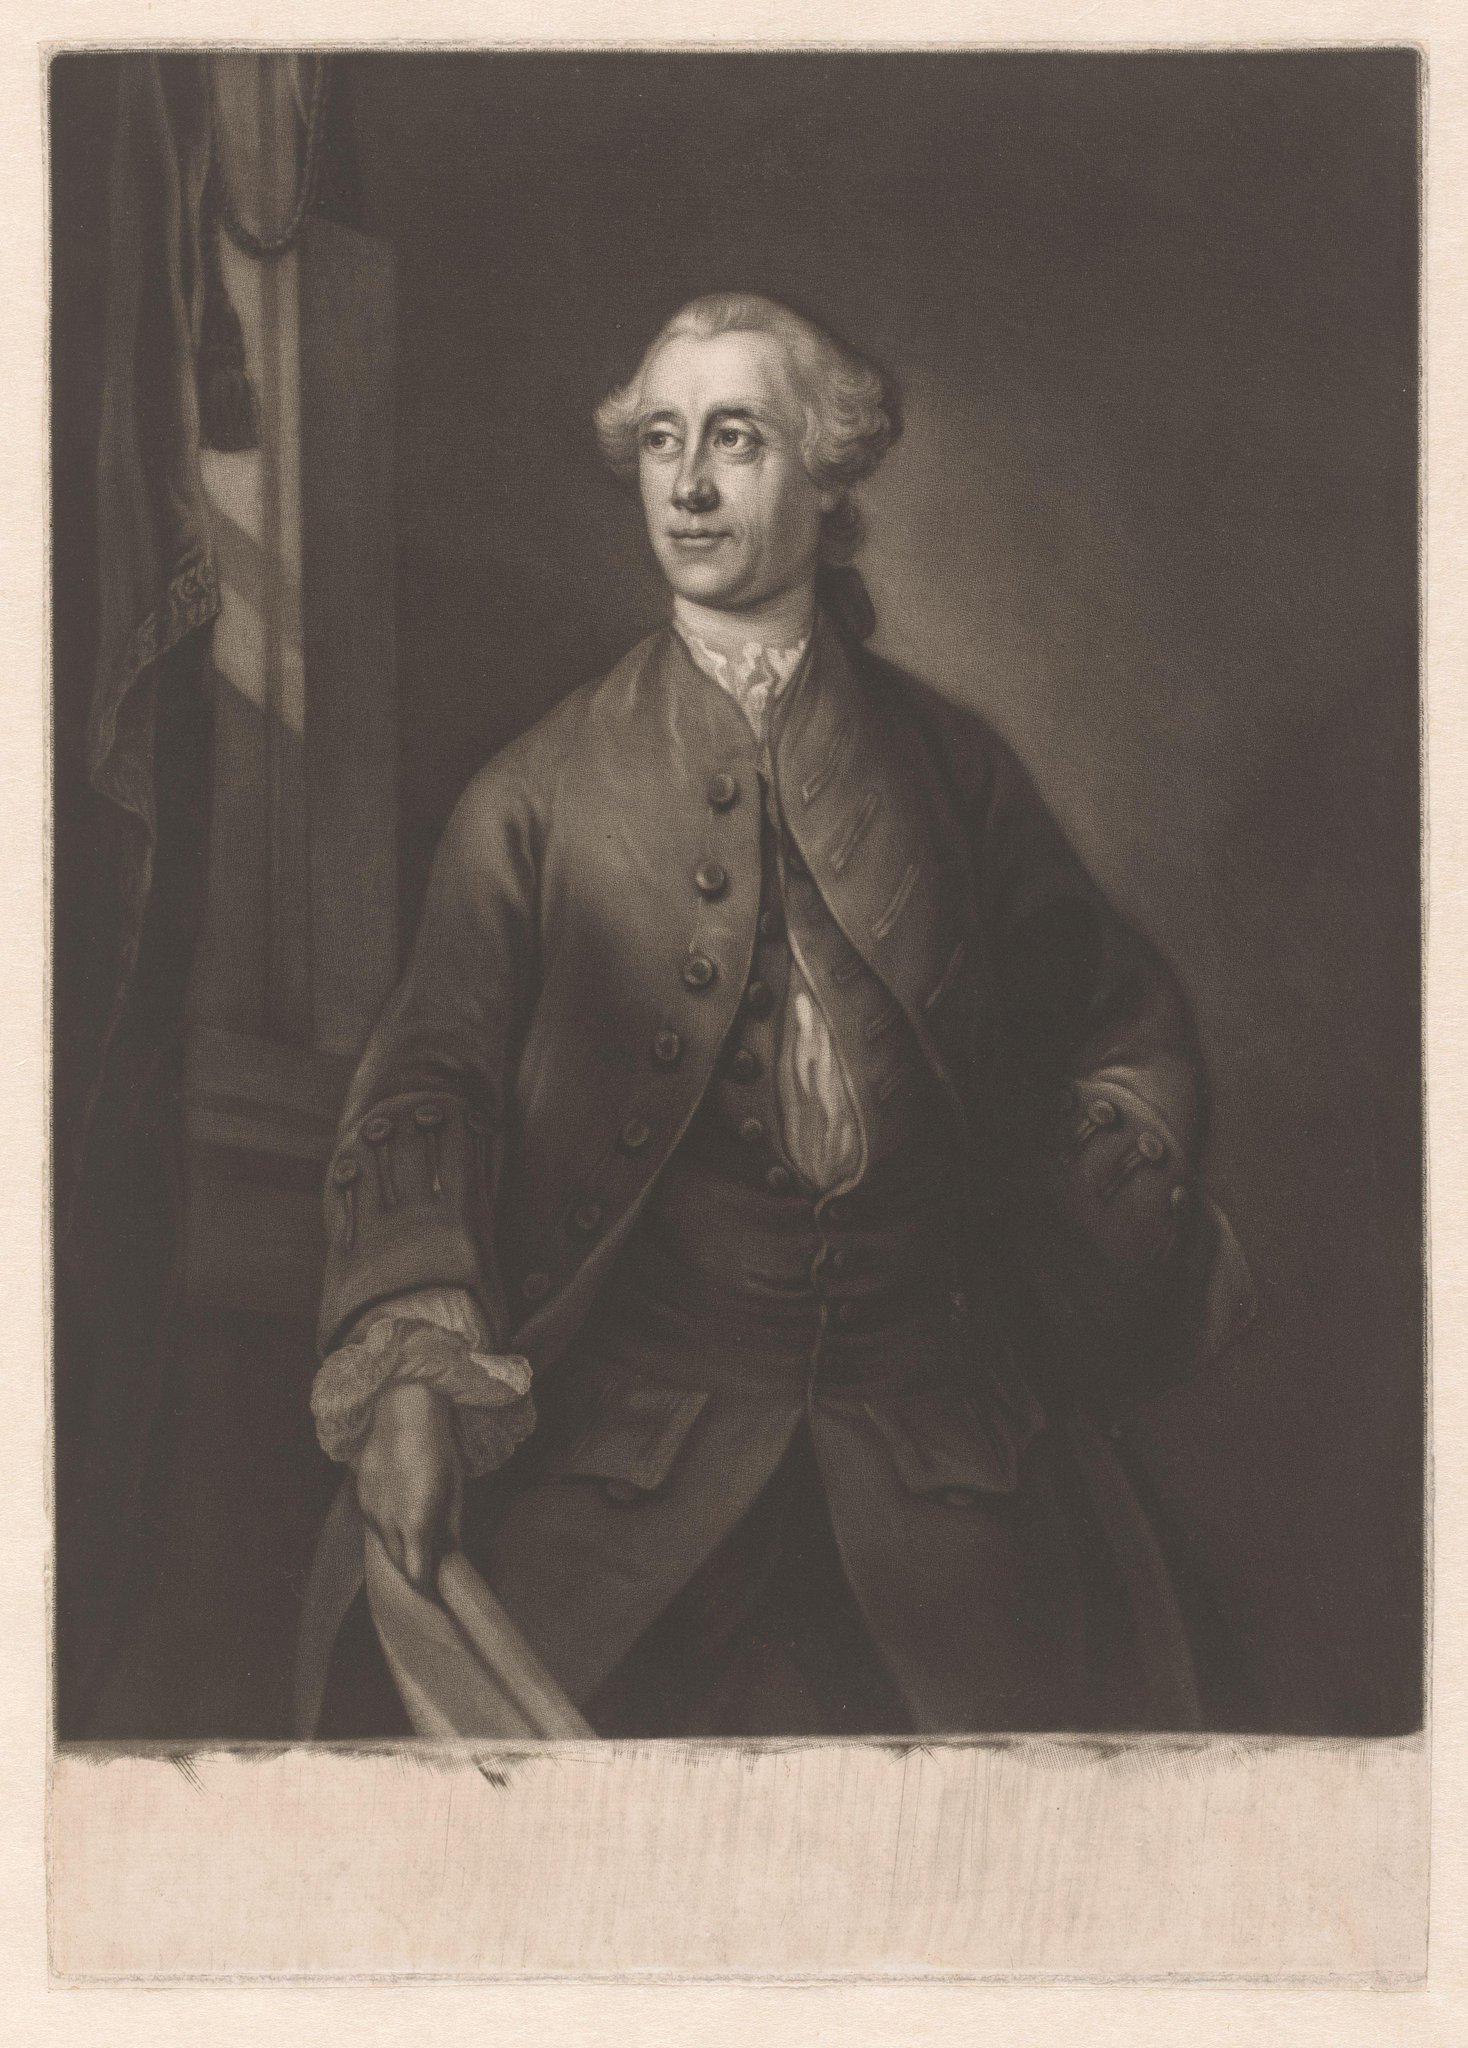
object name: print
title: Portret van Simon Harcourt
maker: james mcardell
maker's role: print maker, publisher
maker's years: 1728-1765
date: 1749-1765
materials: paper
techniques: mezzotint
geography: london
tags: simon harcourt (1e graaf van harcourt), commander-in-chief, general, marshal, historical persons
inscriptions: collector's mark: Lugt 240